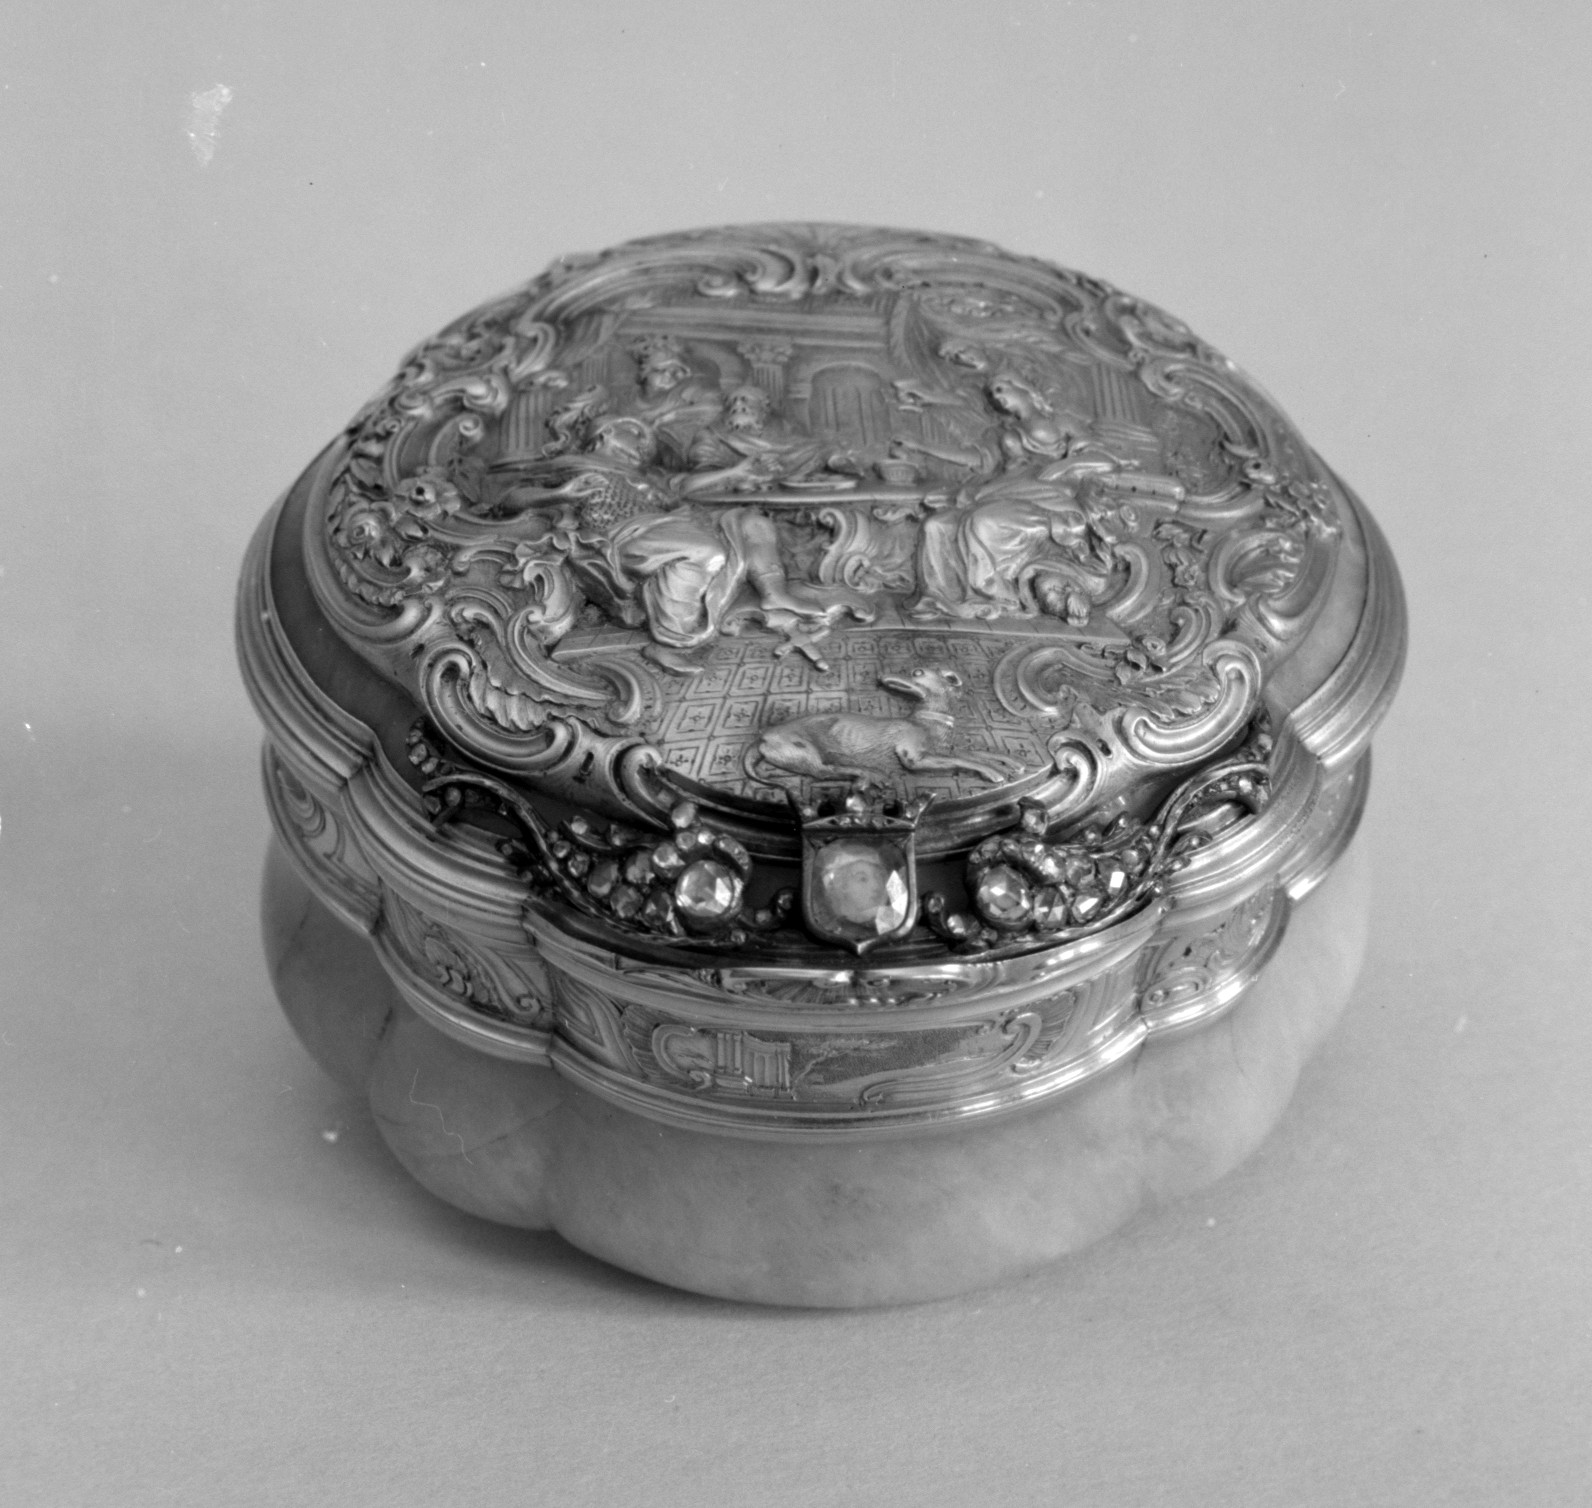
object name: snuffbox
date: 1750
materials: gold, quartz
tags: human figures,animals